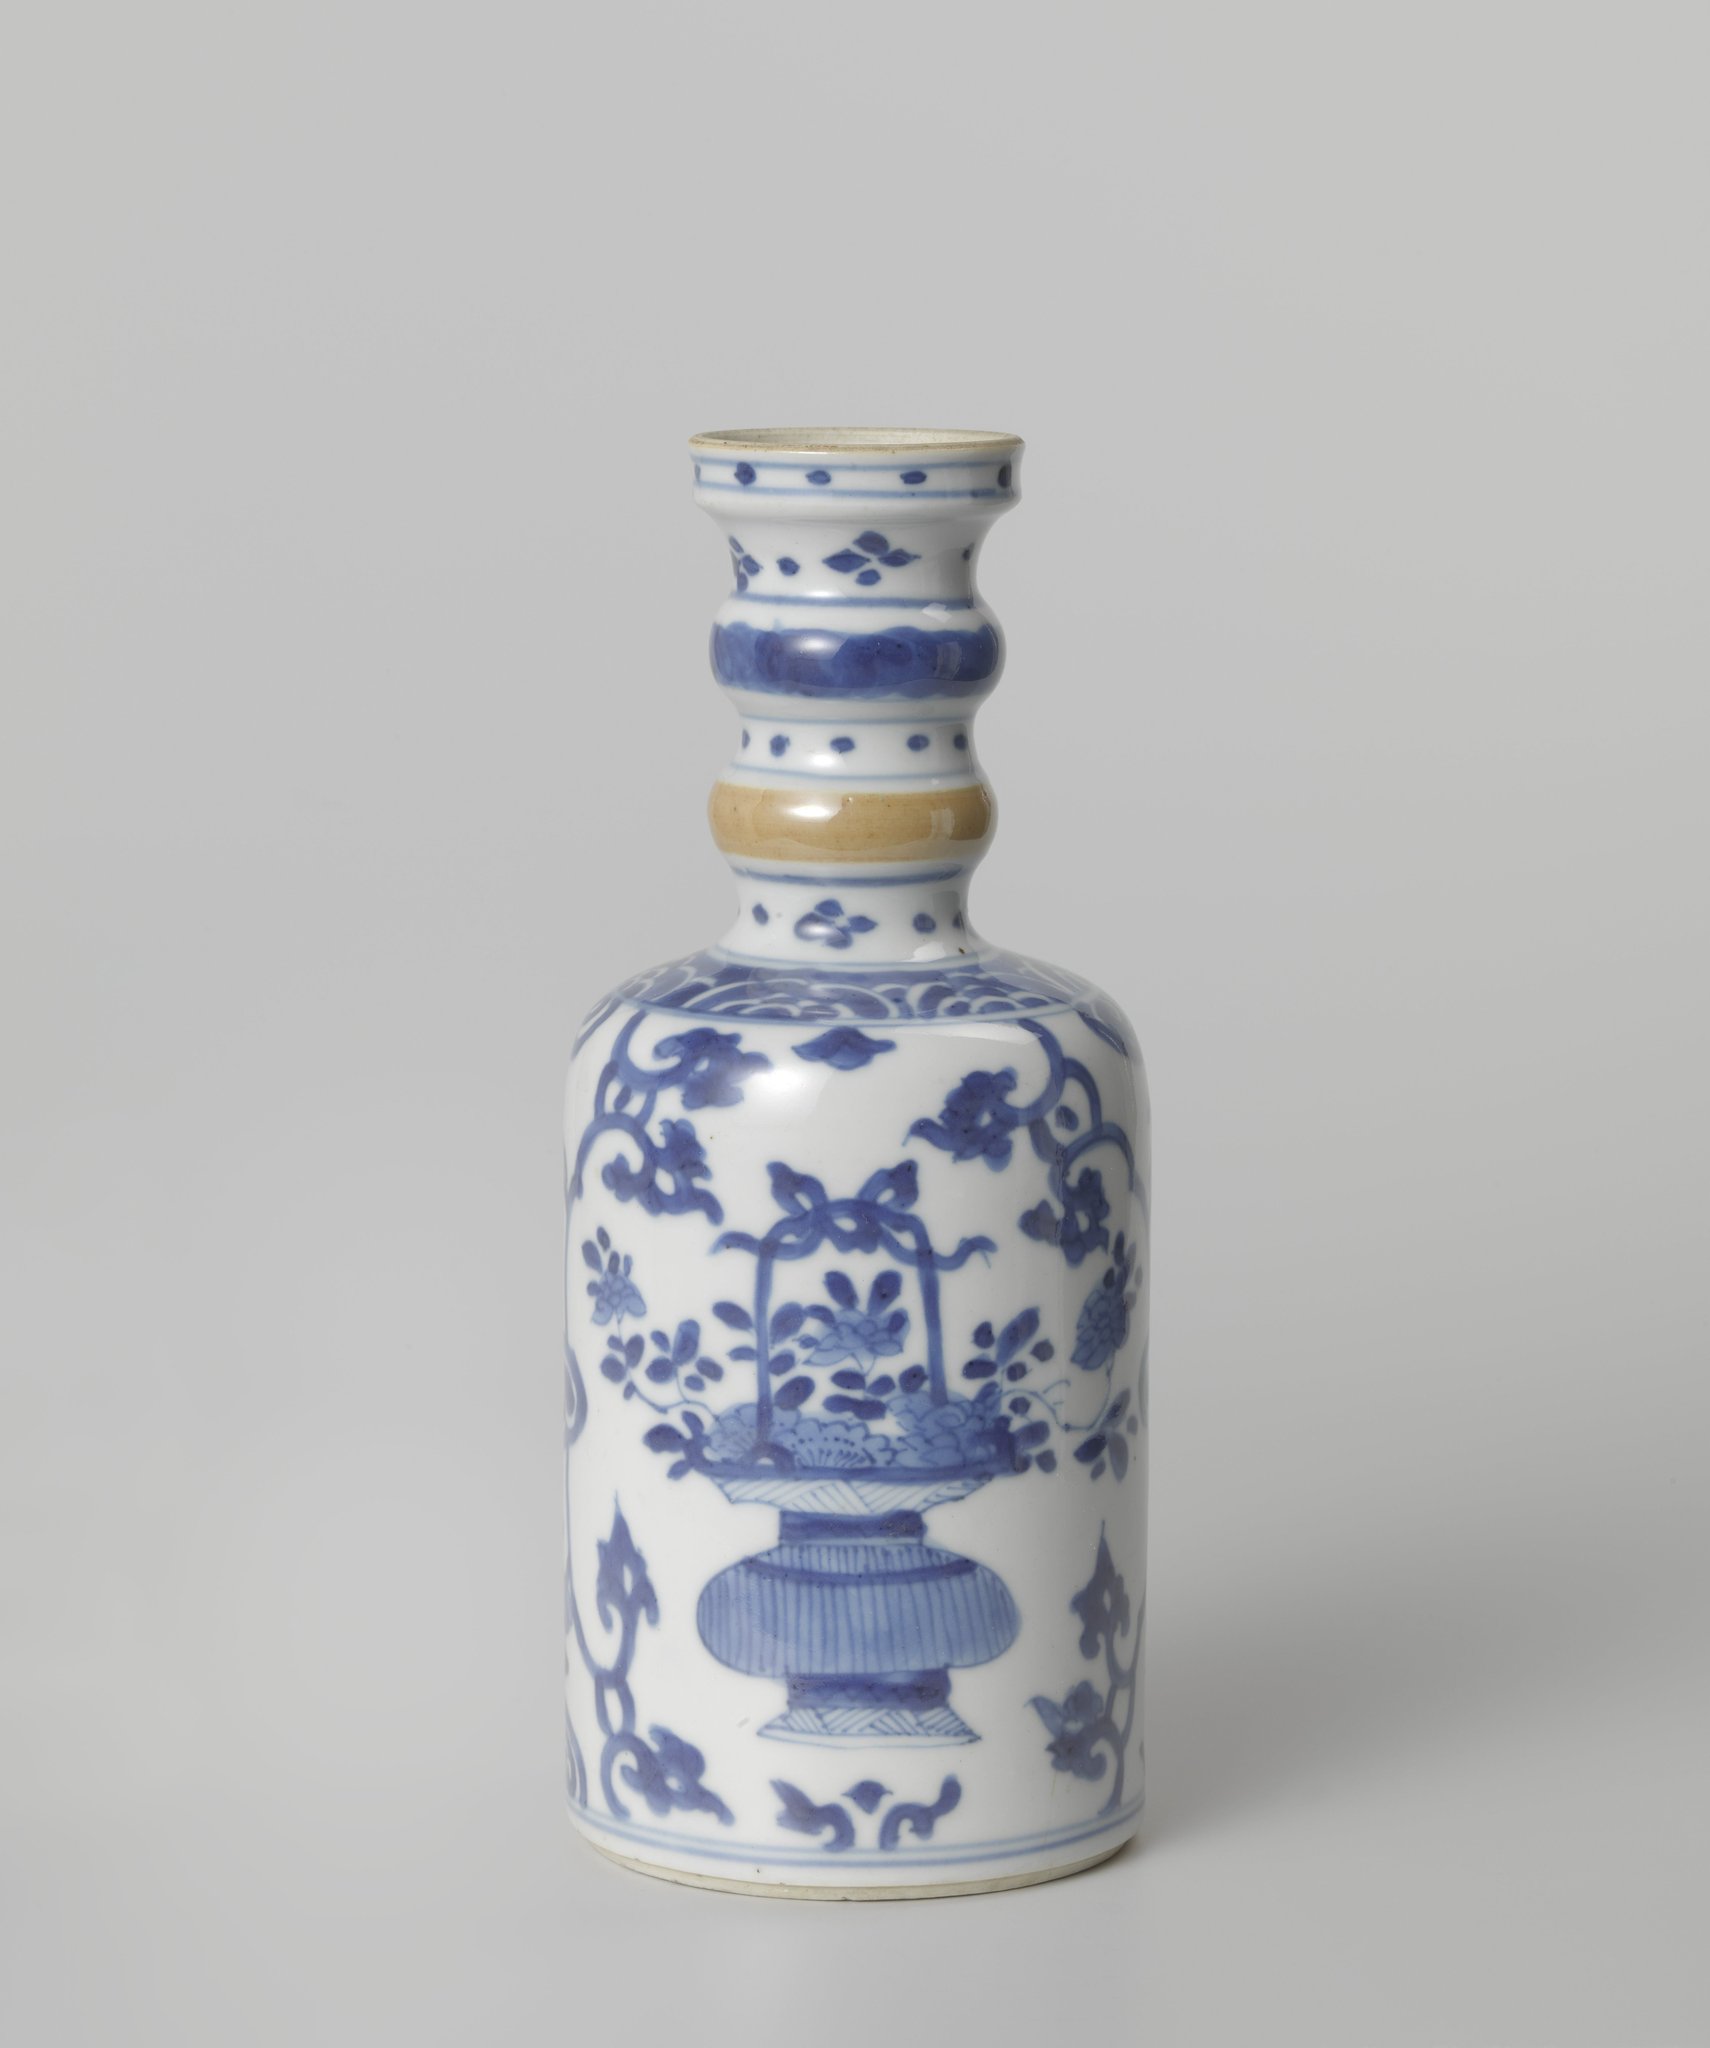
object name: vase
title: Bottle vase with flower baskets and floral scrolls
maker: Anonymous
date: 1680-1720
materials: cobalt, glaze, paint, porcelain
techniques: firing, turning, vitrification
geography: china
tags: ornament derived from plant forms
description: AK-NM-6730 Twee vazen • Blauw-wit Kangxi-porselein • Onderdeel van Royers porseleincollectie • Oorspronkelijk drie exemplaren (Inventaris Van der Kellen 1876) Het is mij niet duidelijk hoe de vorm van dit flesje met de verdikkingen in de hals en de opstaande lip verklaard kunnen worden. Het brengt in de verte porseleinen waterpijpstandaards in gedachte, maar die hebben een echt ‘kommetje’ als mondstuk en een boller lichaam. Misschien is deze ingewikkelde hals alleen voor de sier op deze manier gemaakt. De mand met bloemen is een element dat weliswaar al op Kraakporselein voorkomt (zie porselein uit de San Diego, 1600) maar op deze manier, met het staande hengsel, pas in de Kangxi-tijd algemeen wordt. De bloemenmanden op Kraakporselein hebben overhet algemeen een andere vorm. Een identiek exemplaar bevindt zich in het British Museum, Londen (Franks.286) en in de collectie van Kasteel Keukenhof.